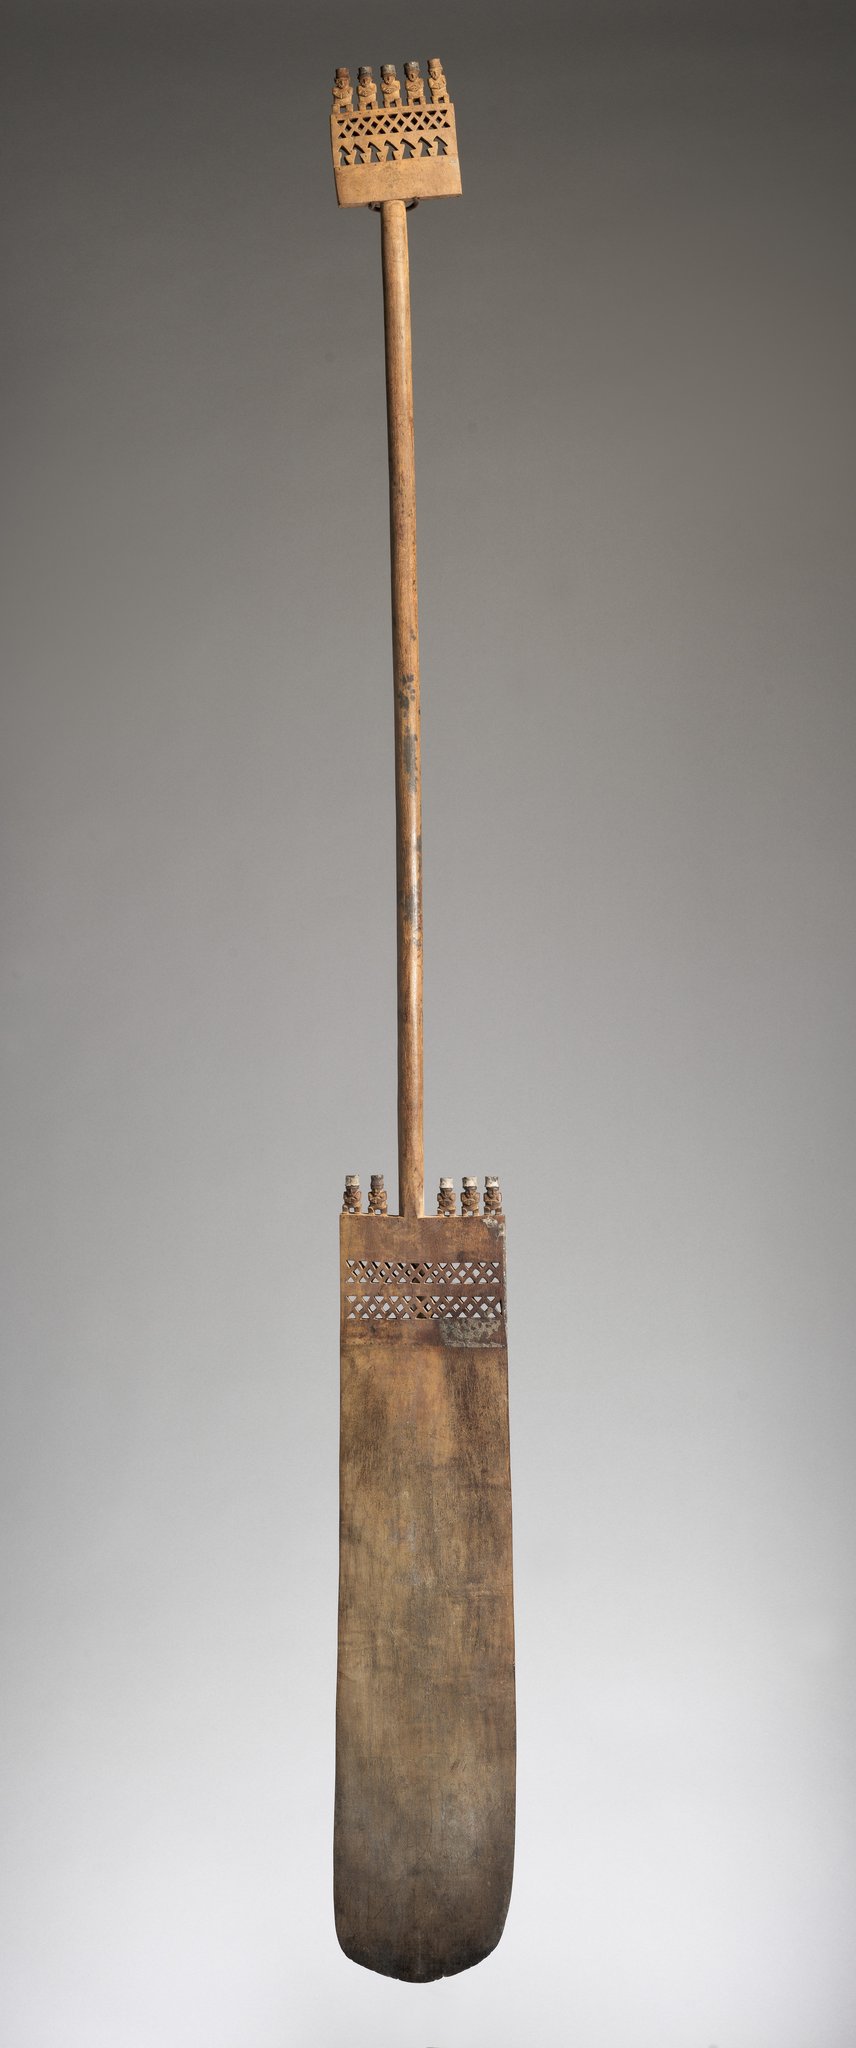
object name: tomb post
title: Ceremonial digging stick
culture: inca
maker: chincha artist(s)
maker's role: artist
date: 1200-1535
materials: silver, wood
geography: peru